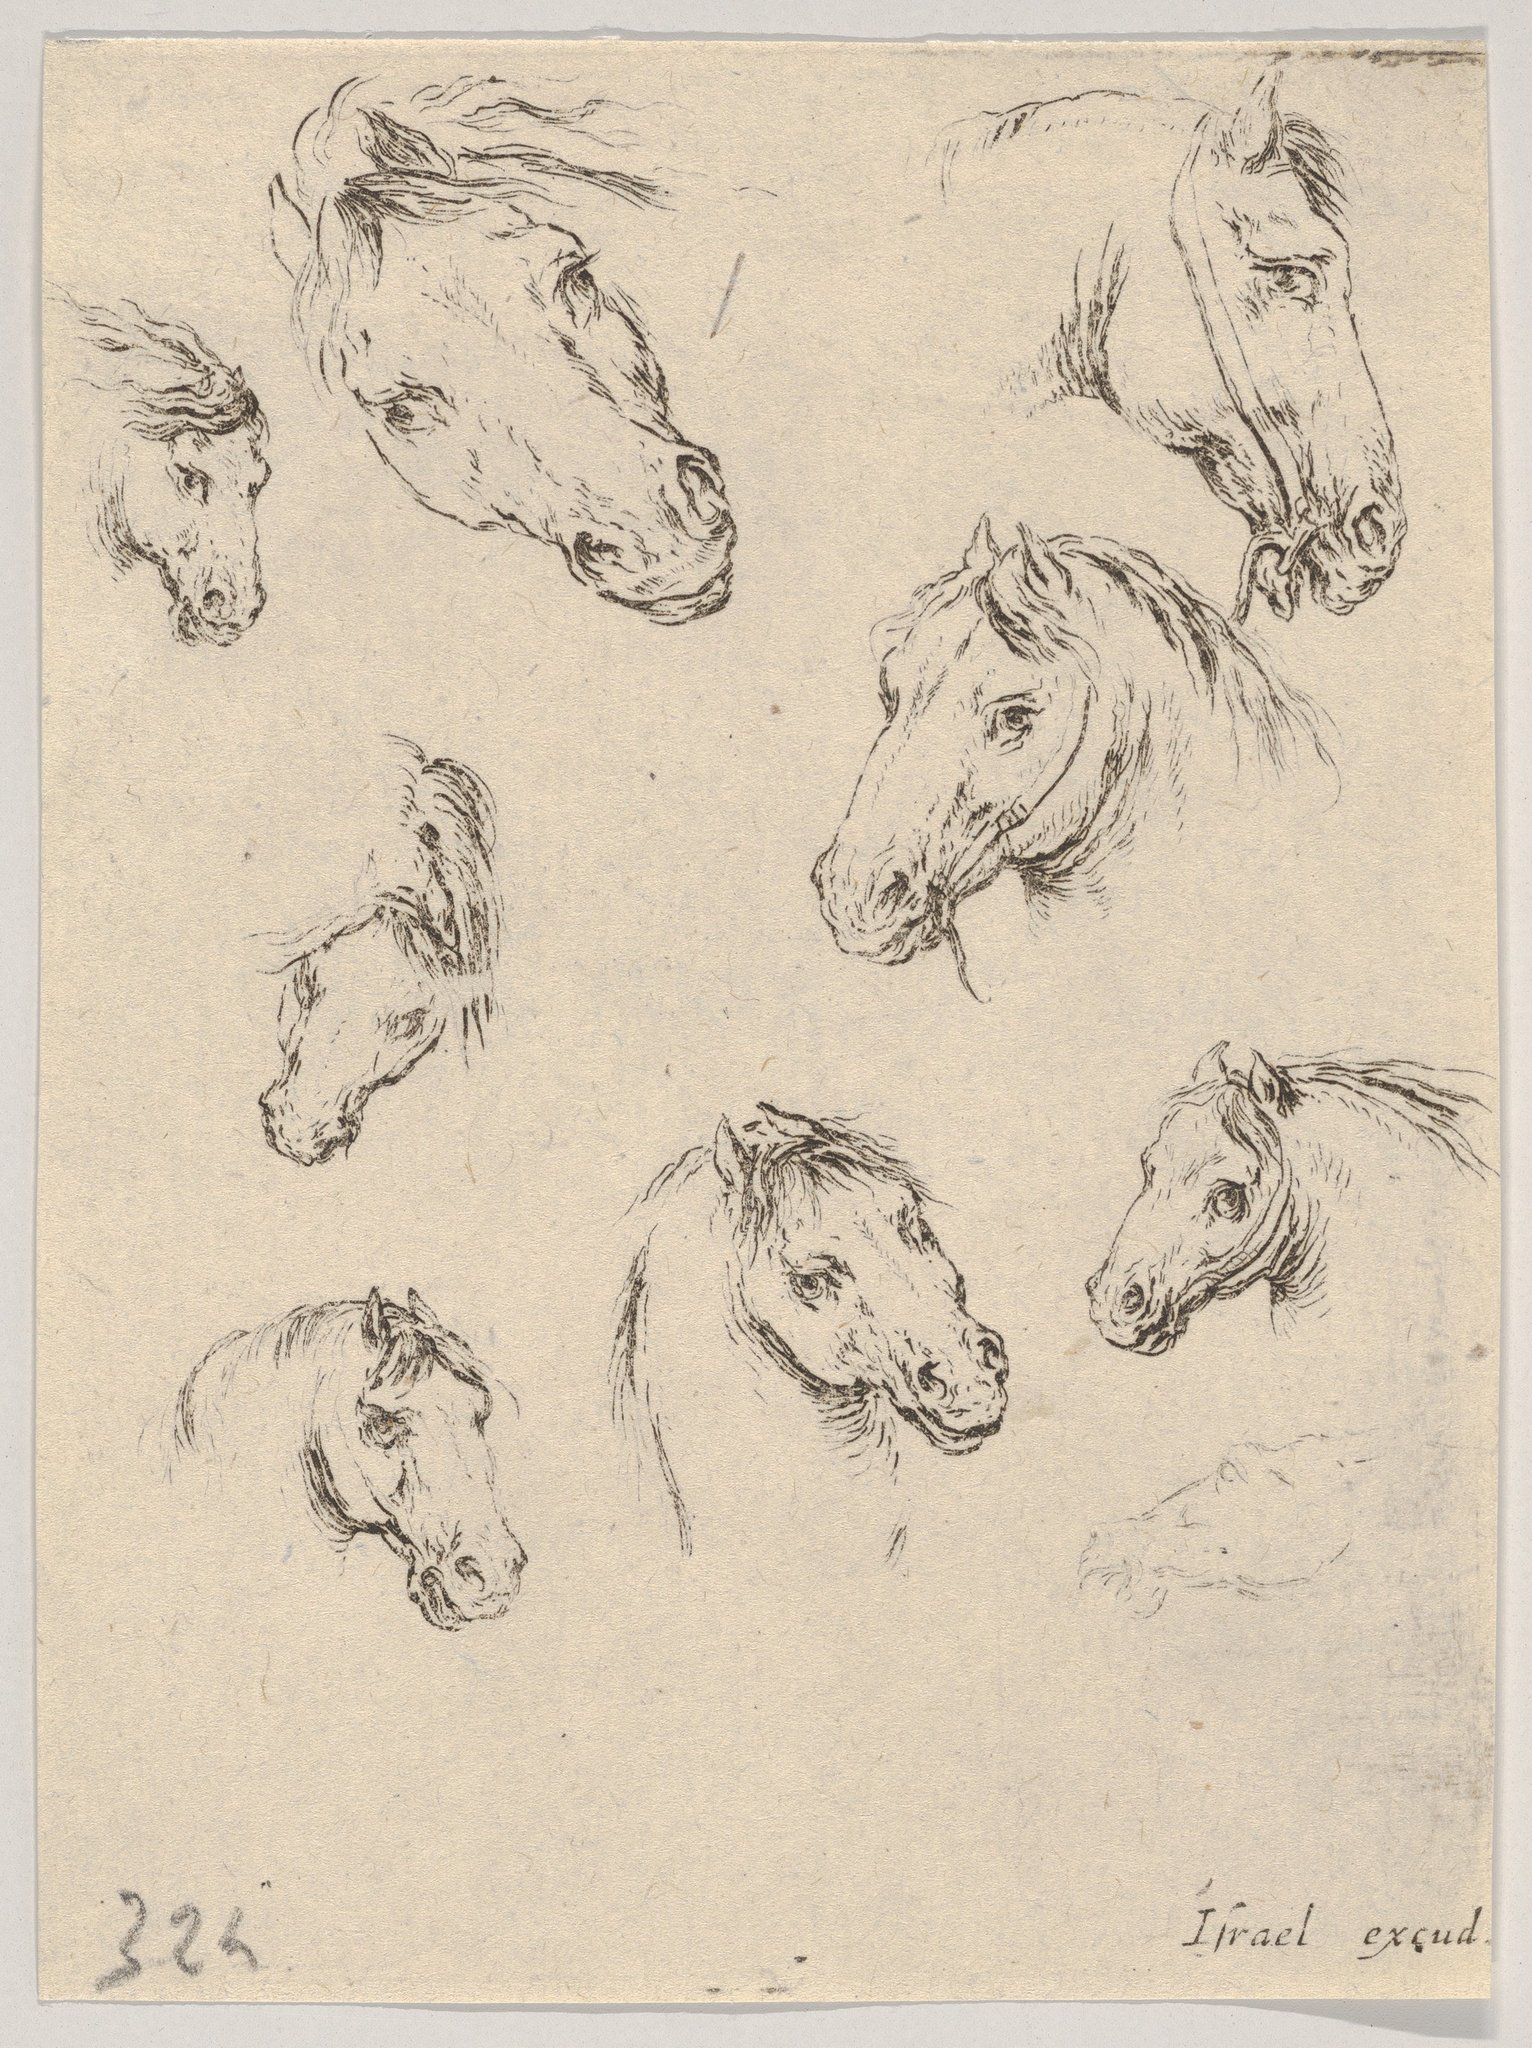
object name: print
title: Plate 17: Nine studies of horse heads, from "Various heads and figures" (Diverses têtes et figures)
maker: stefano della bella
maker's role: artist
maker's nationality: italian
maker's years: 1610-1664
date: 1650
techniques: etching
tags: horses